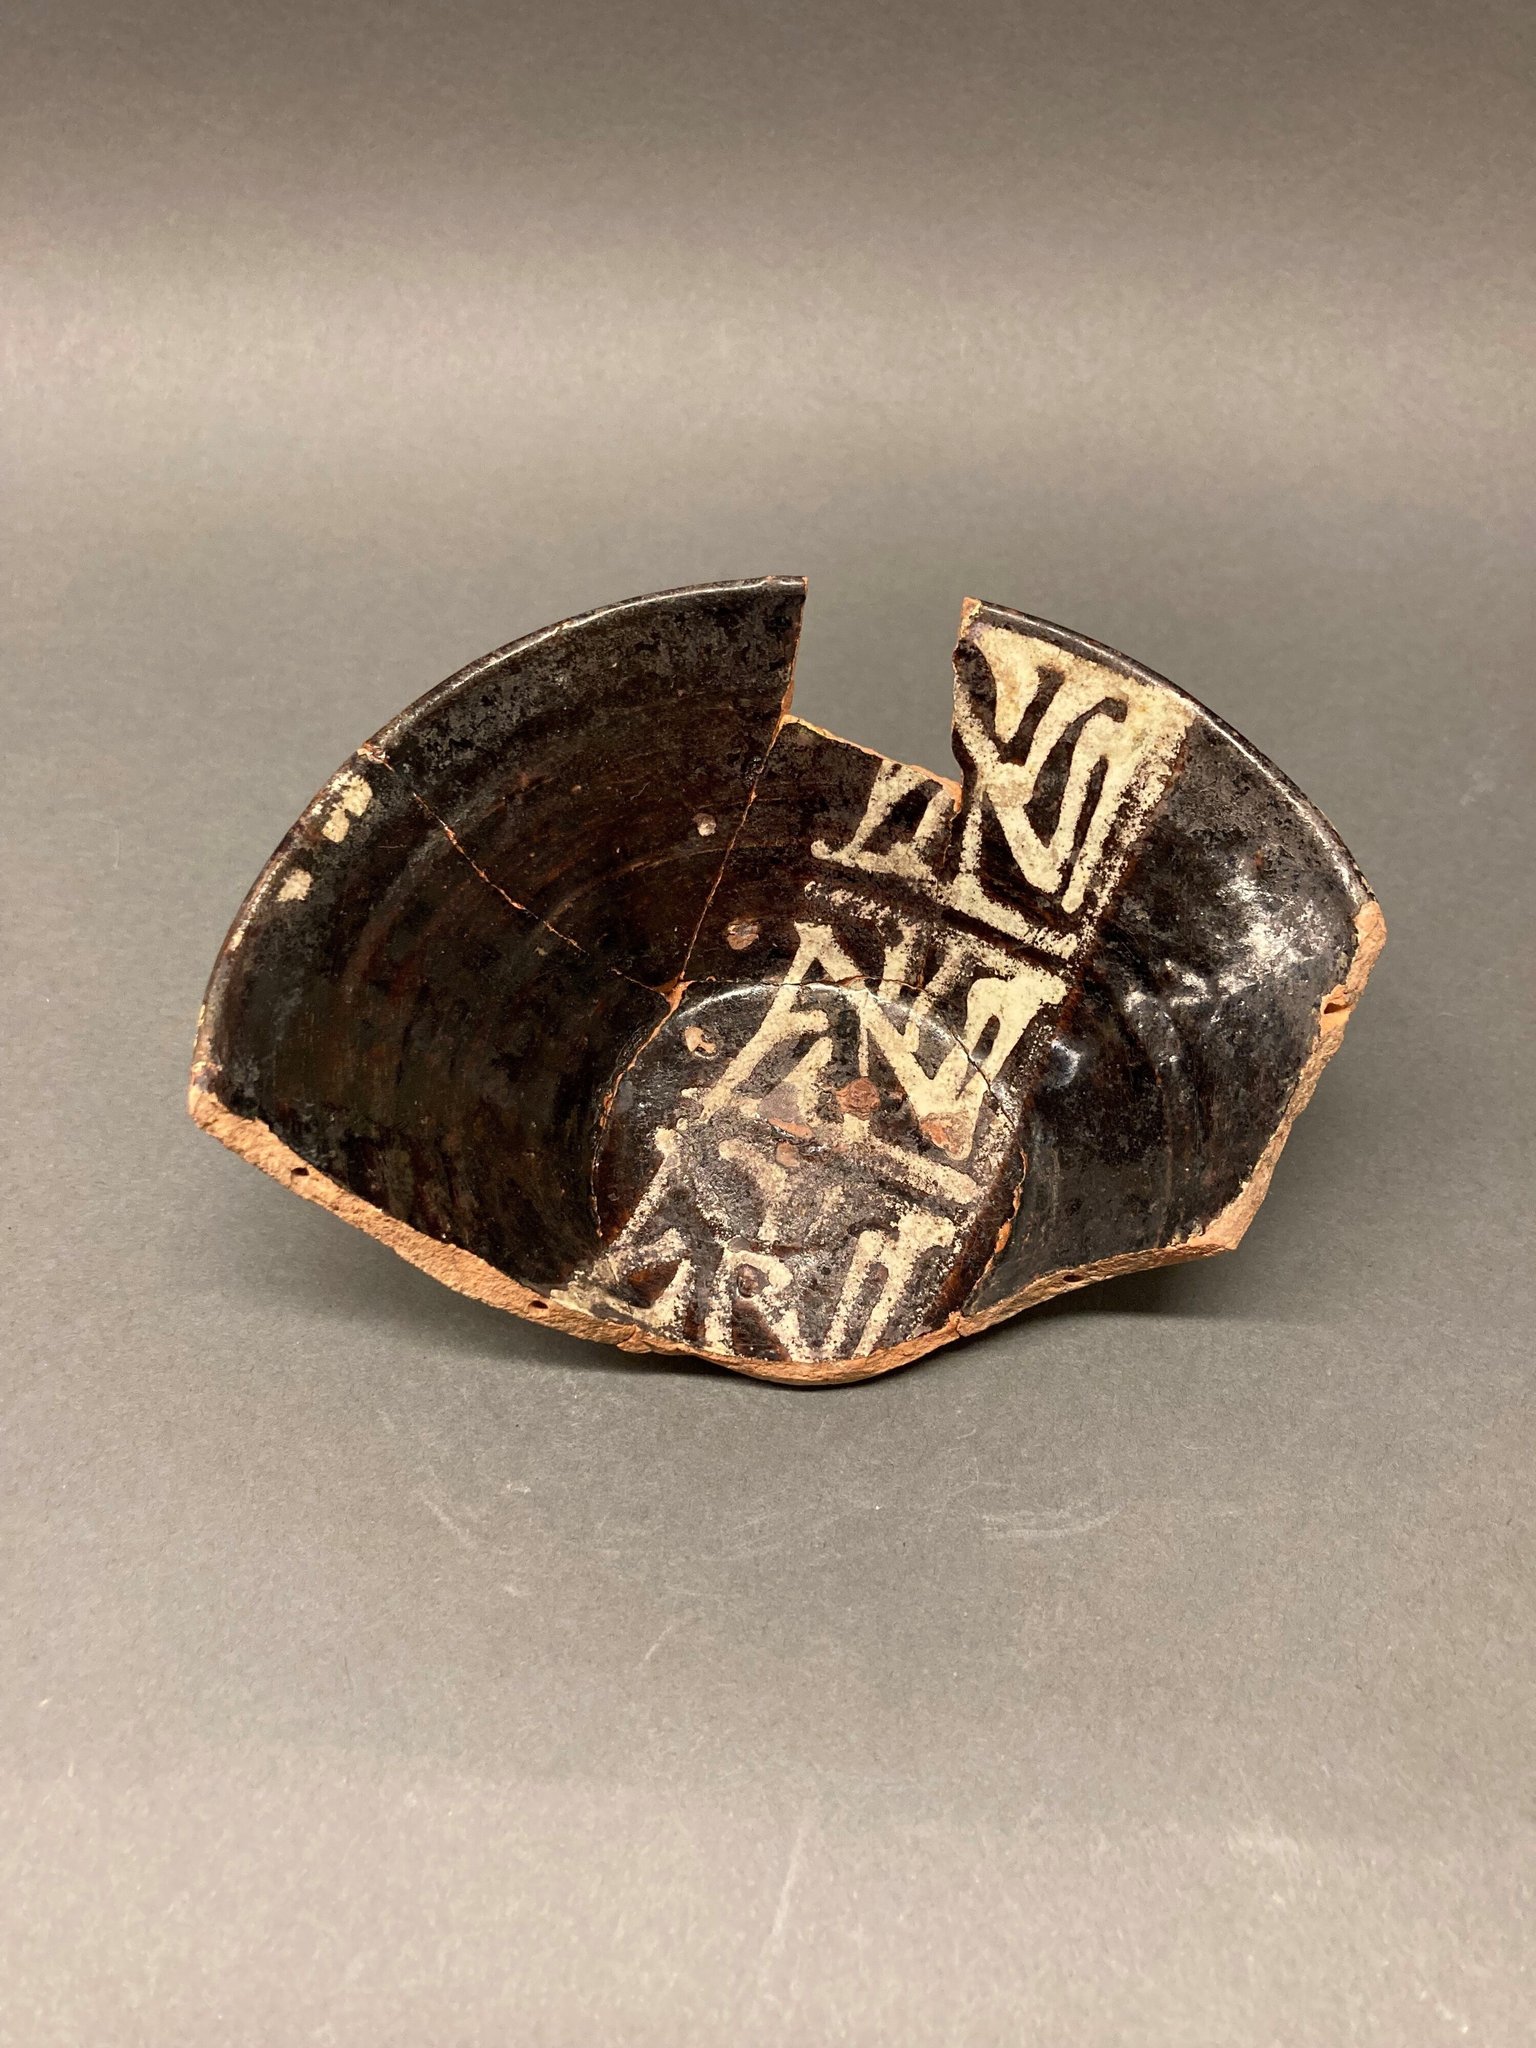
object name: bowl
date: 901-1000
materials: earthenware, glaze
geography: iran